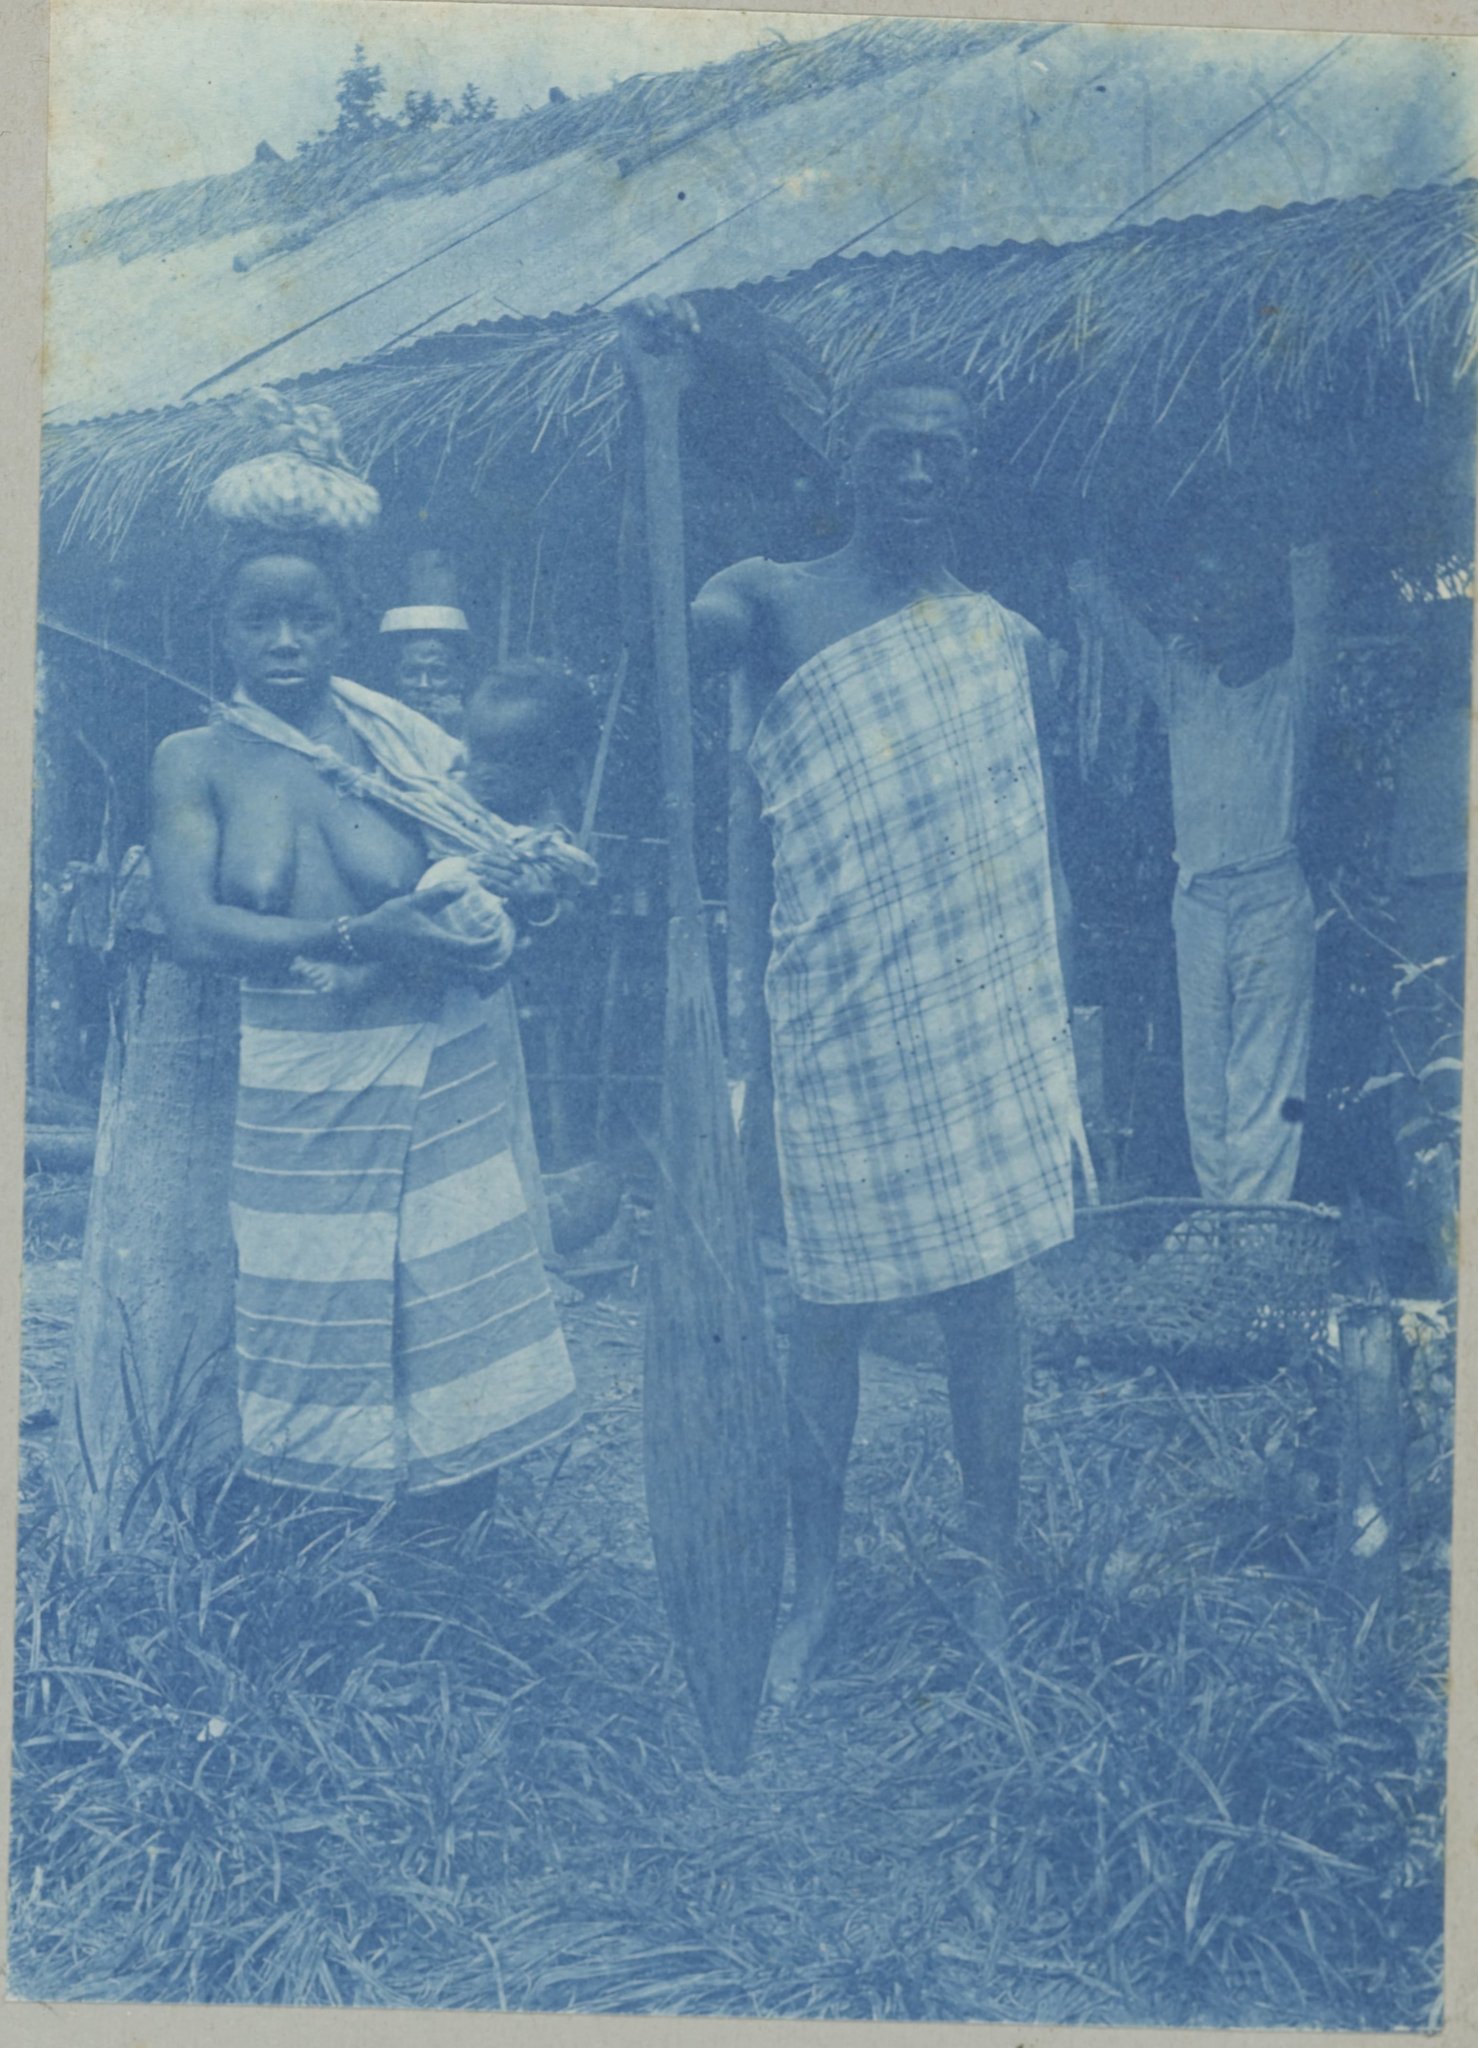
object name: photograph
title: Boschnegergezin uit Gansé op Kwakoegron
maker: hendrik doijer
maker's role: engineer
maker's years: 1863-1925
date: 1903-1910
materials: photographic support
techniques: cyanotype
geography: suriname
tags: suriname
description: Marrongezin uit het dorp Gansee staande voor een huis te Kwakoegron, de man houdt zijn hand op een houten roeispaan. Onderdeel van het fotoalbum Souvenir de Voyage (deel 1), over het leven van de familie Doijer in en rond de plantage Ma Retraite in Suriname in de jaren 1903-1910.